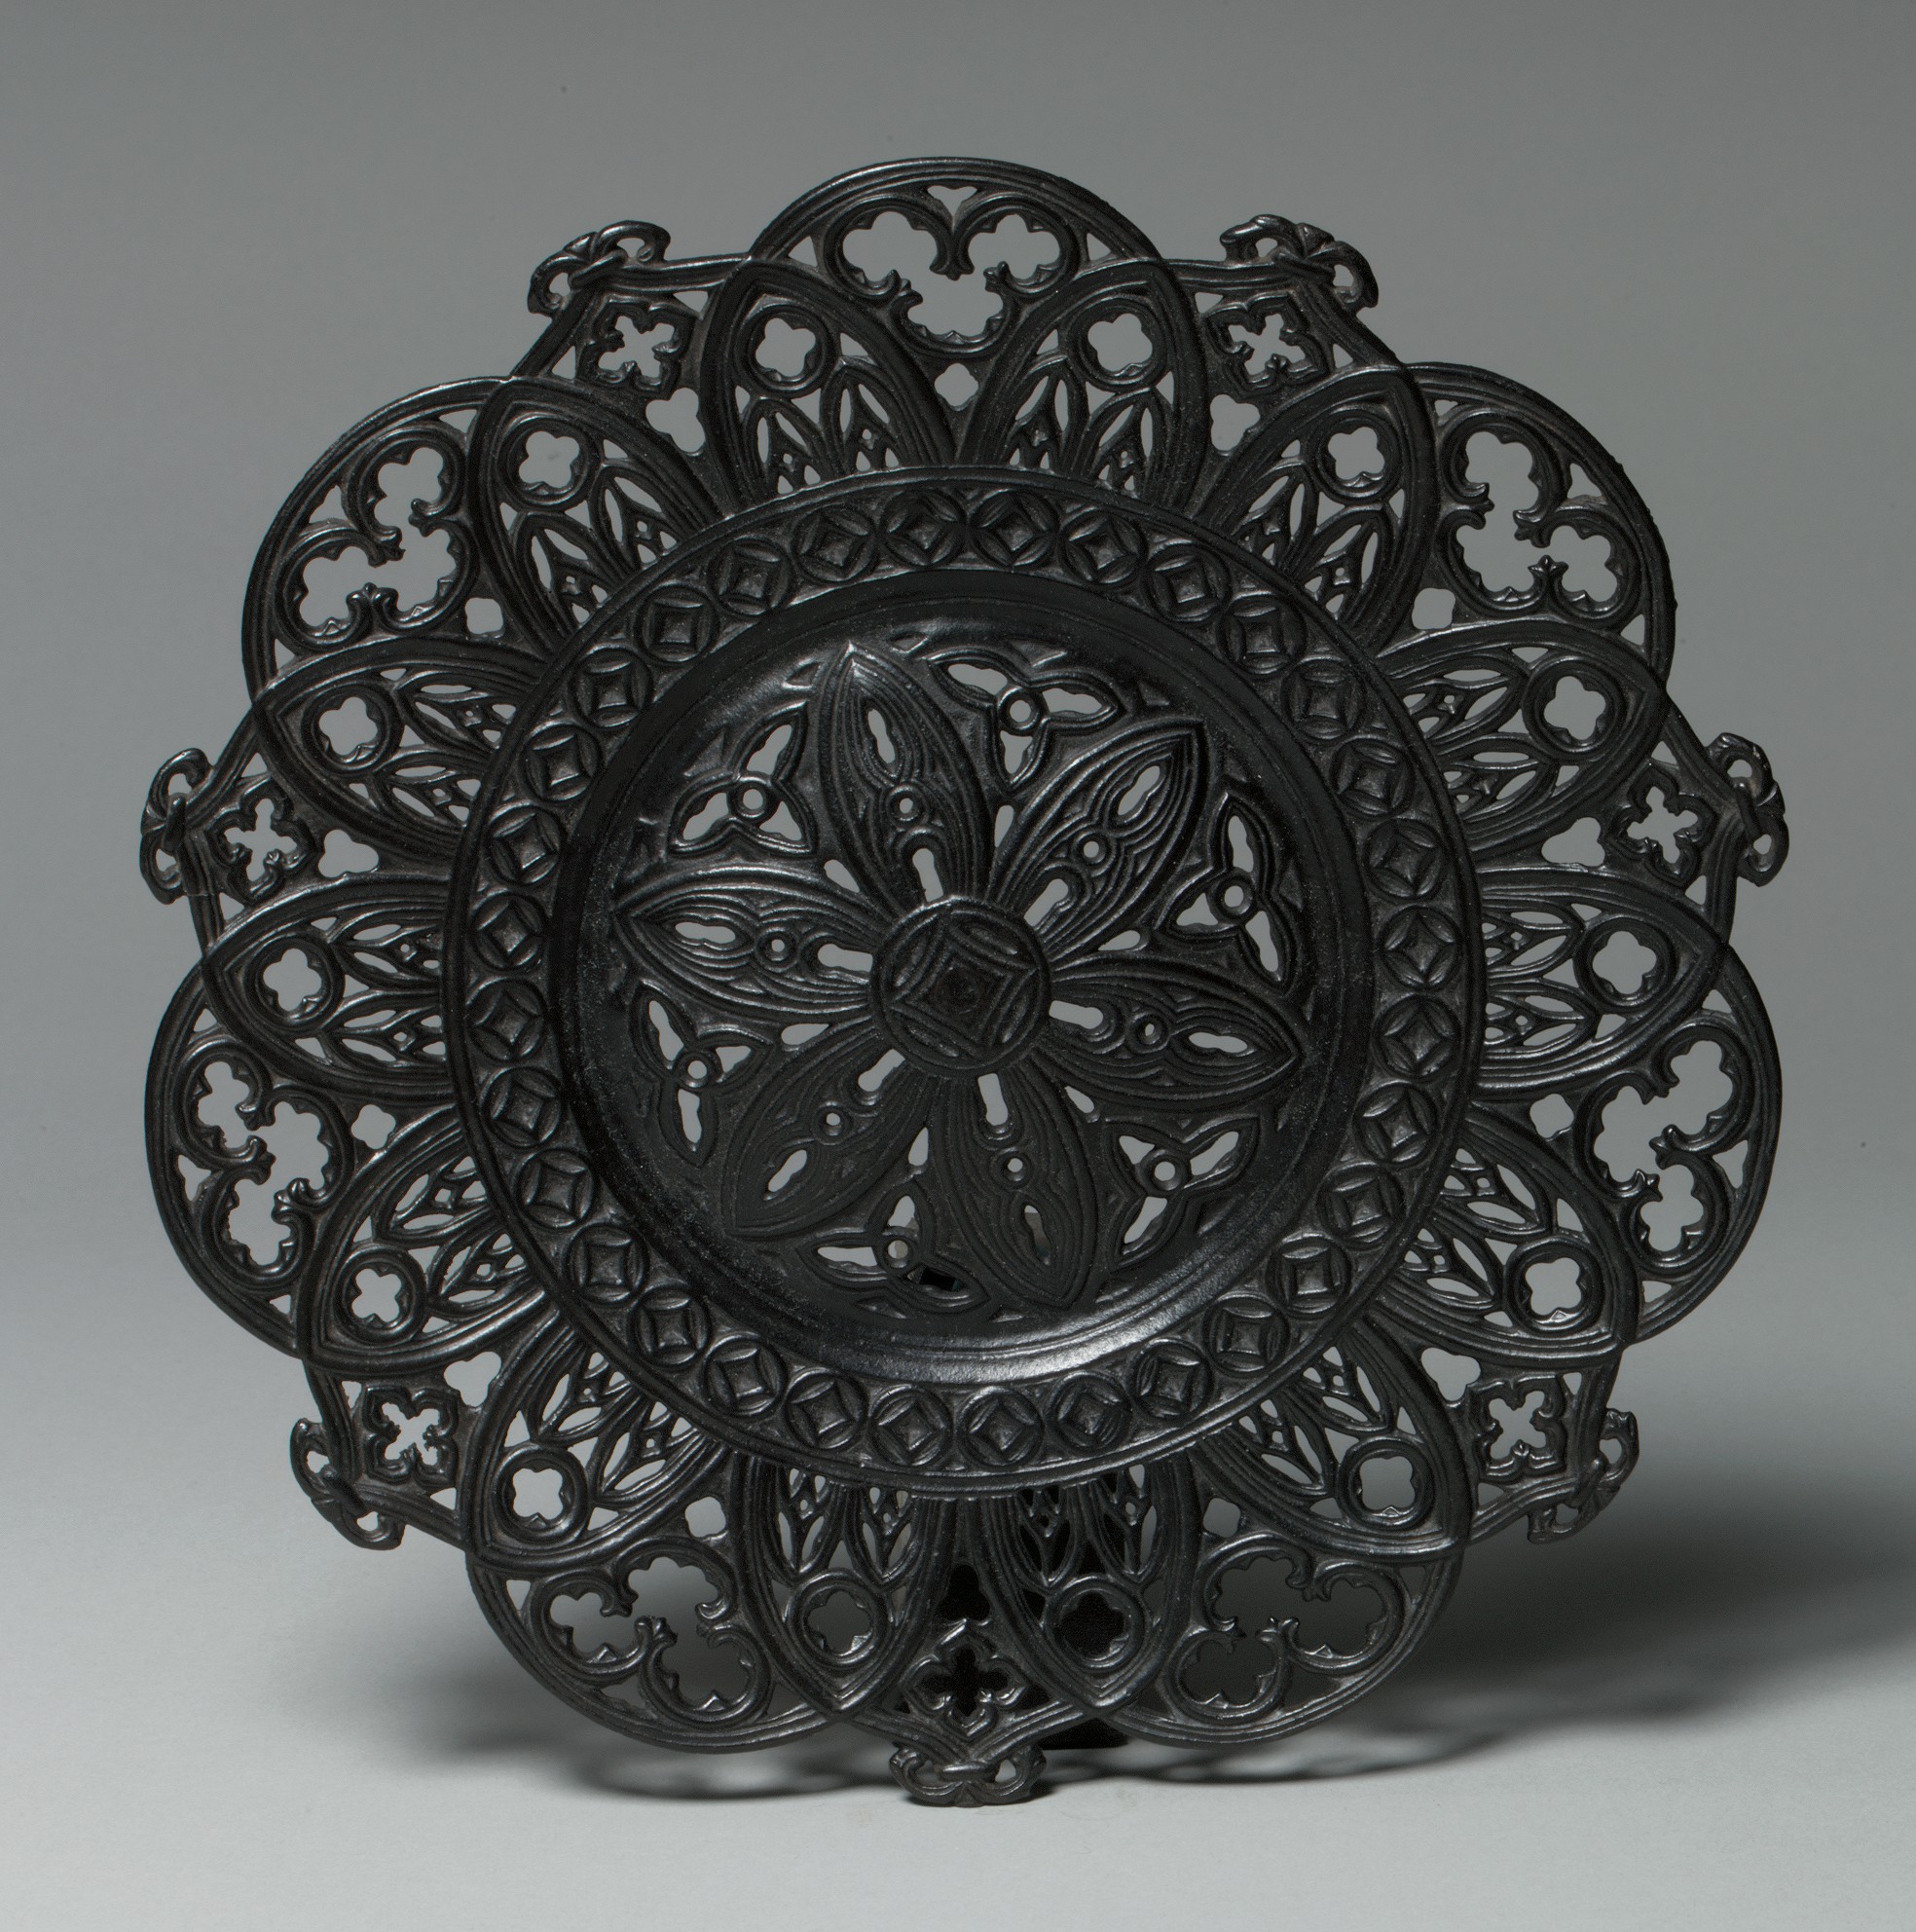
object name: plate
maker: kaslinski ironworks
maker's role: manufacturer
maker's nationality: russian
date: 1834-1866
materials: iron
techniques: casting